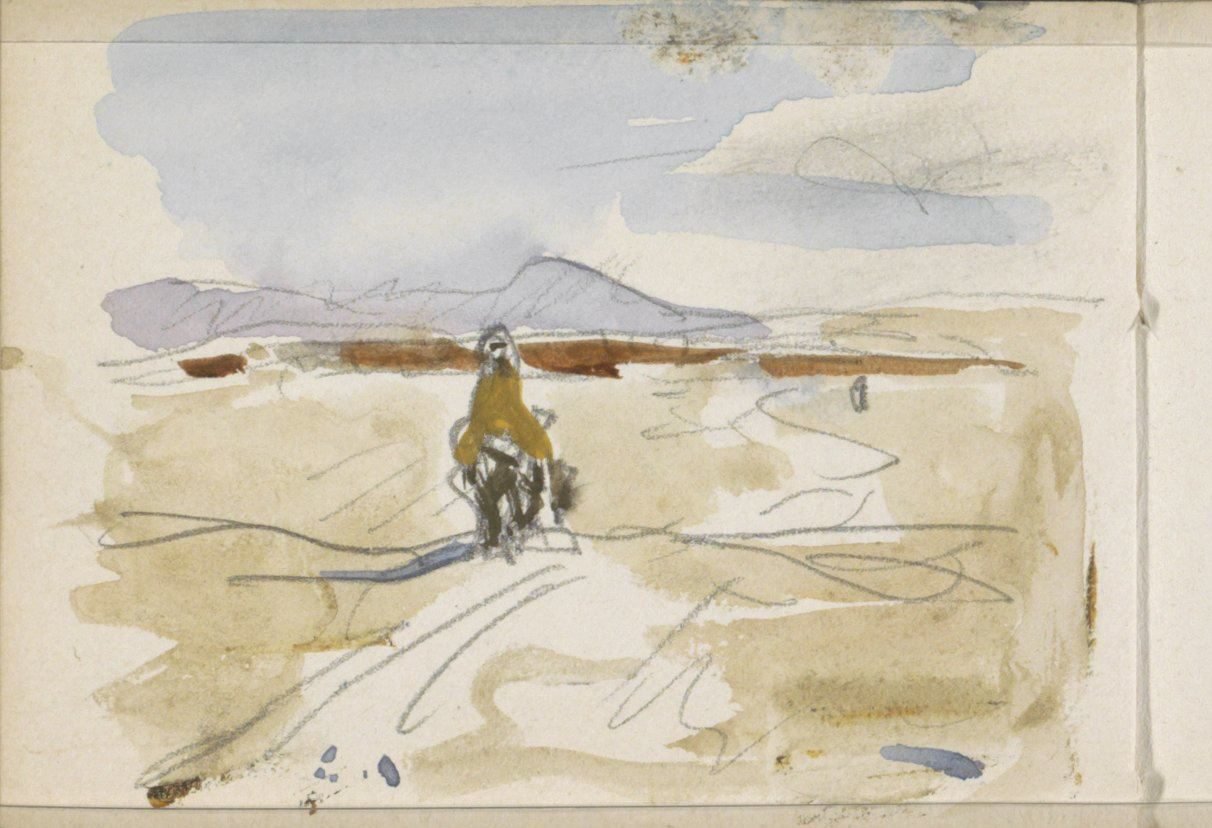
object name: sketchbook leaf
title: Figuur op een kameel in een woestijnlandschap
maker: marius bauer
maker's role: draughtsman, print maker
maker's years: 1867-1932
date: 1922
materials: paper, pencil, watercolor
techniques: brush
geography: biskra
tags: hoofed animals: camel, sitting figure, desert, mountains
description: Op de achtergrond vermoedelijk het Atlasgebergte. Pagina 44 uit een schetsboek met 32 bladen.